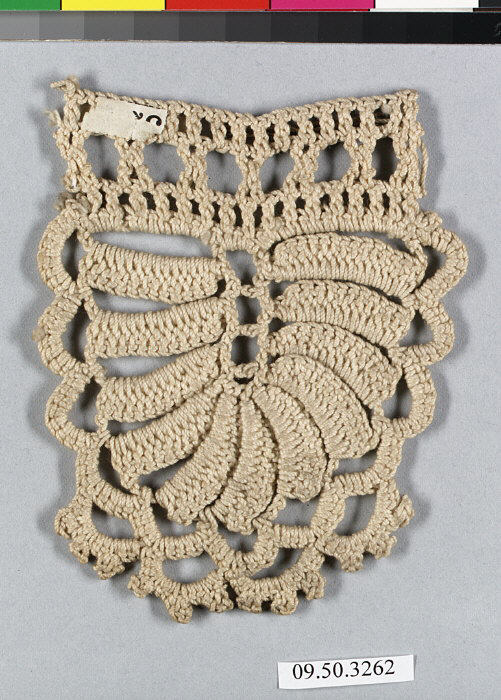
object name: sample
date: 1801-1900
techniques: crochet